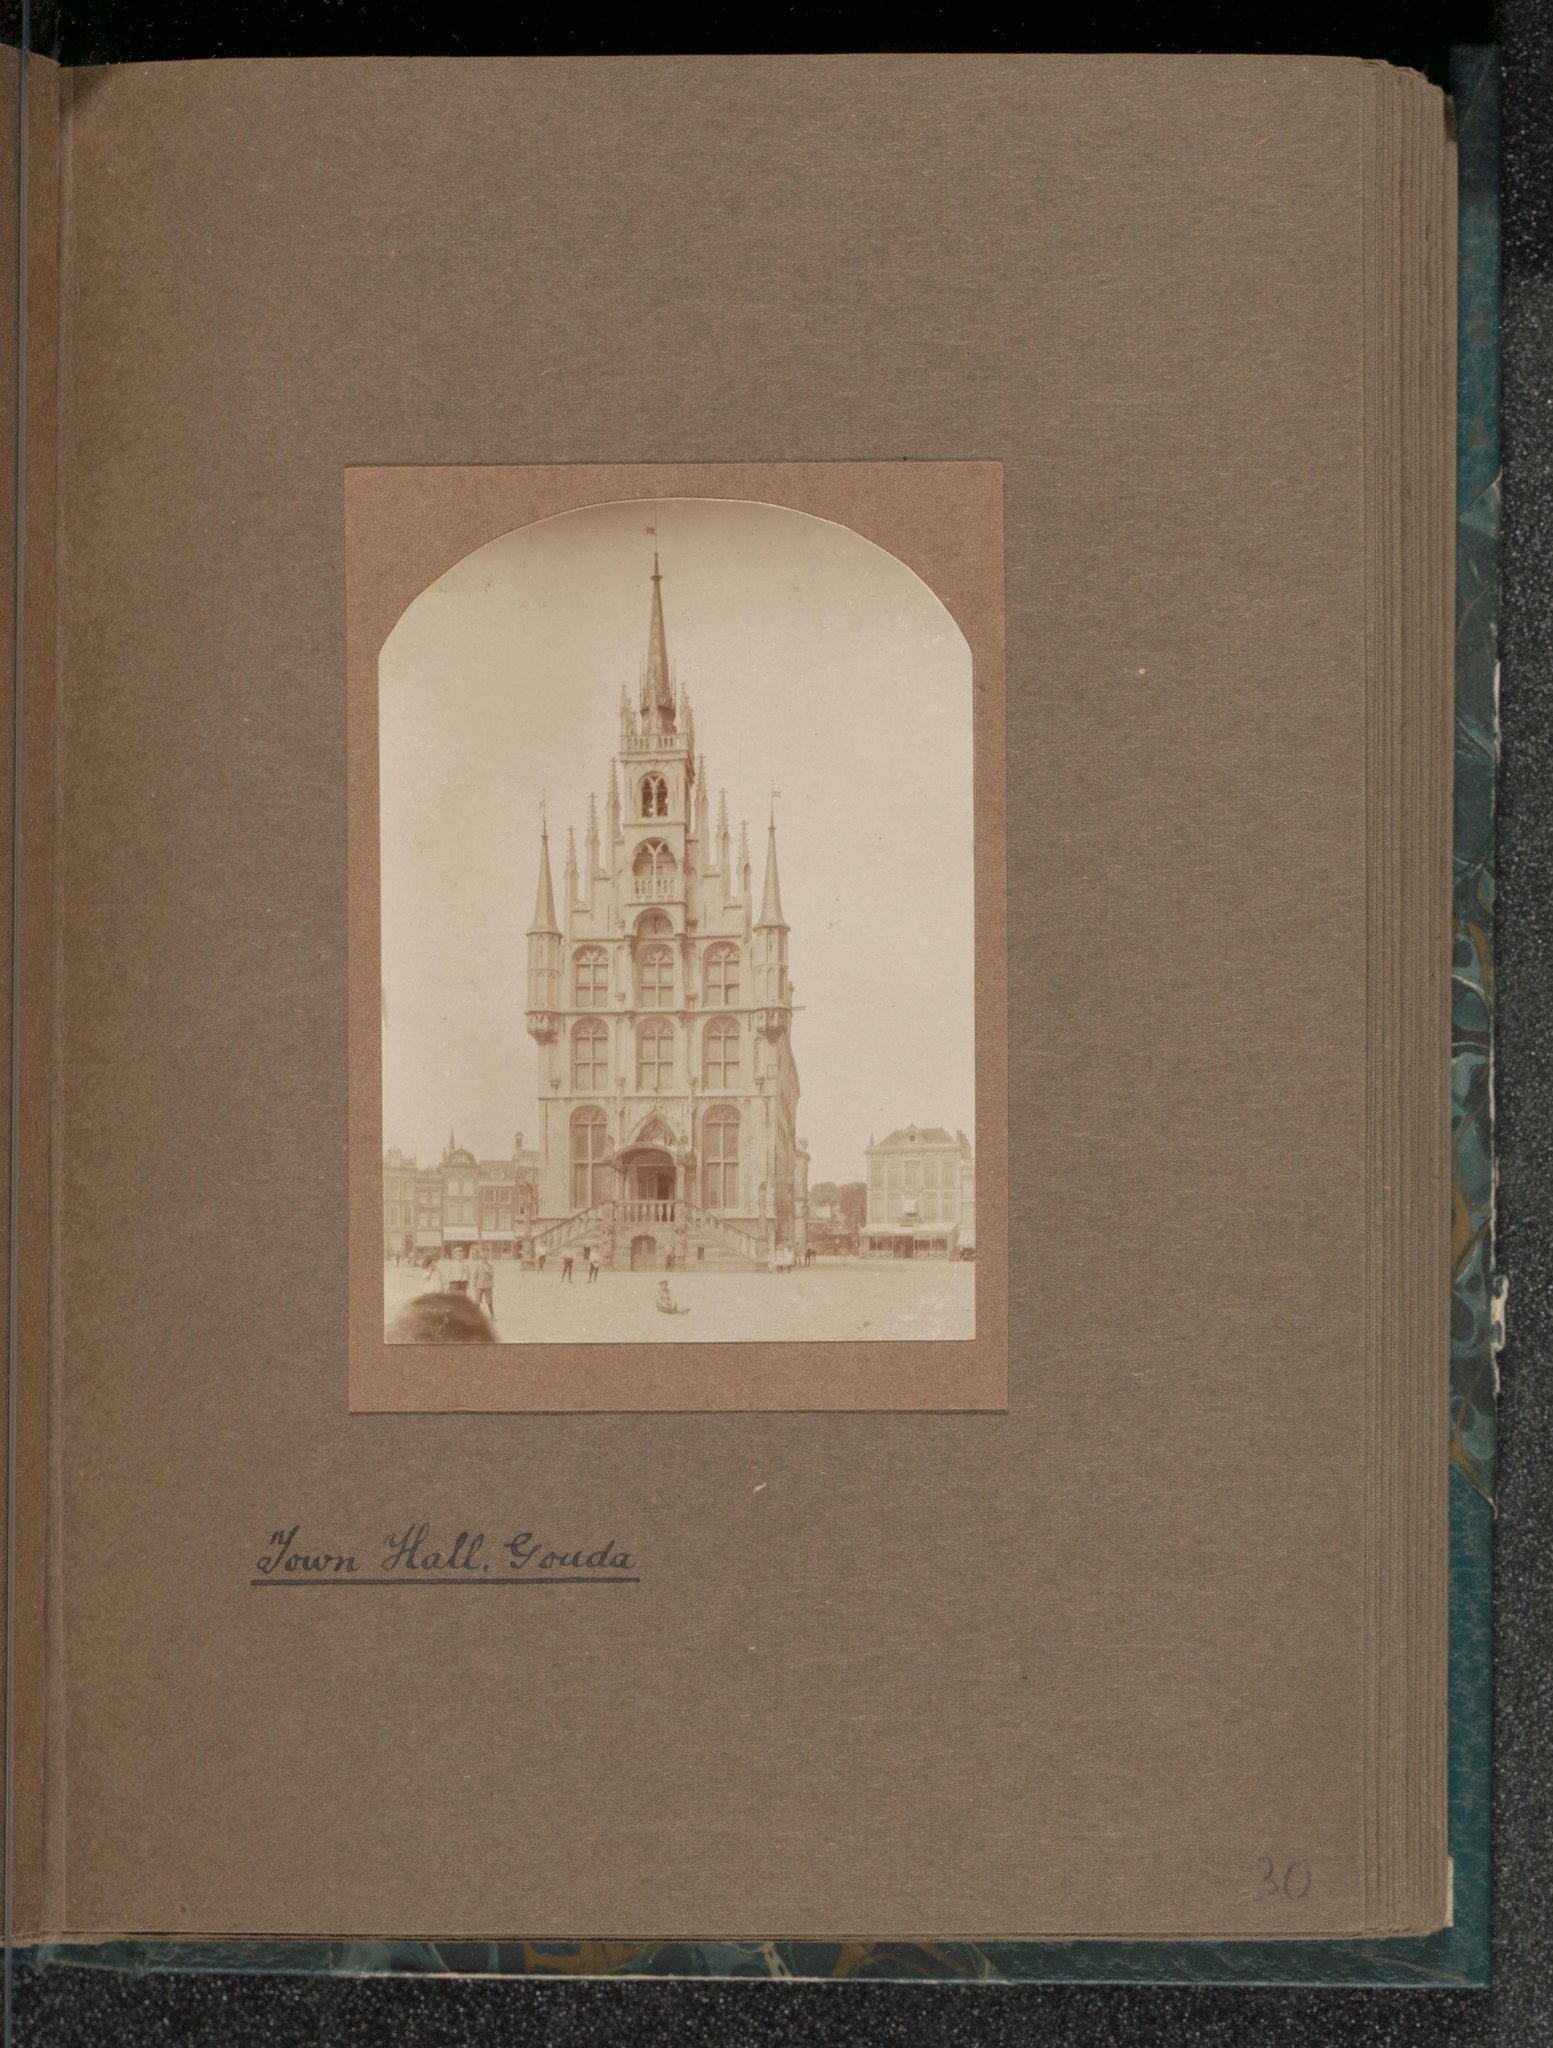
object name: photograph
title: Town Hall Gouda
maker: Anonymous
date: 1912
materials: photographic support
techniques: gelatin silver print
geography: gouda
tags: tower, clock tower ~ monumental adornment, townhall, travelling; tourism, square, place, circus, etc. (+ city(-scape) with figures, staffage), gouda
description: Onderdeel van Fotoalbum van de excursie naar Nederland van de Britse amateurfotografenvereniging P.C.U.K.